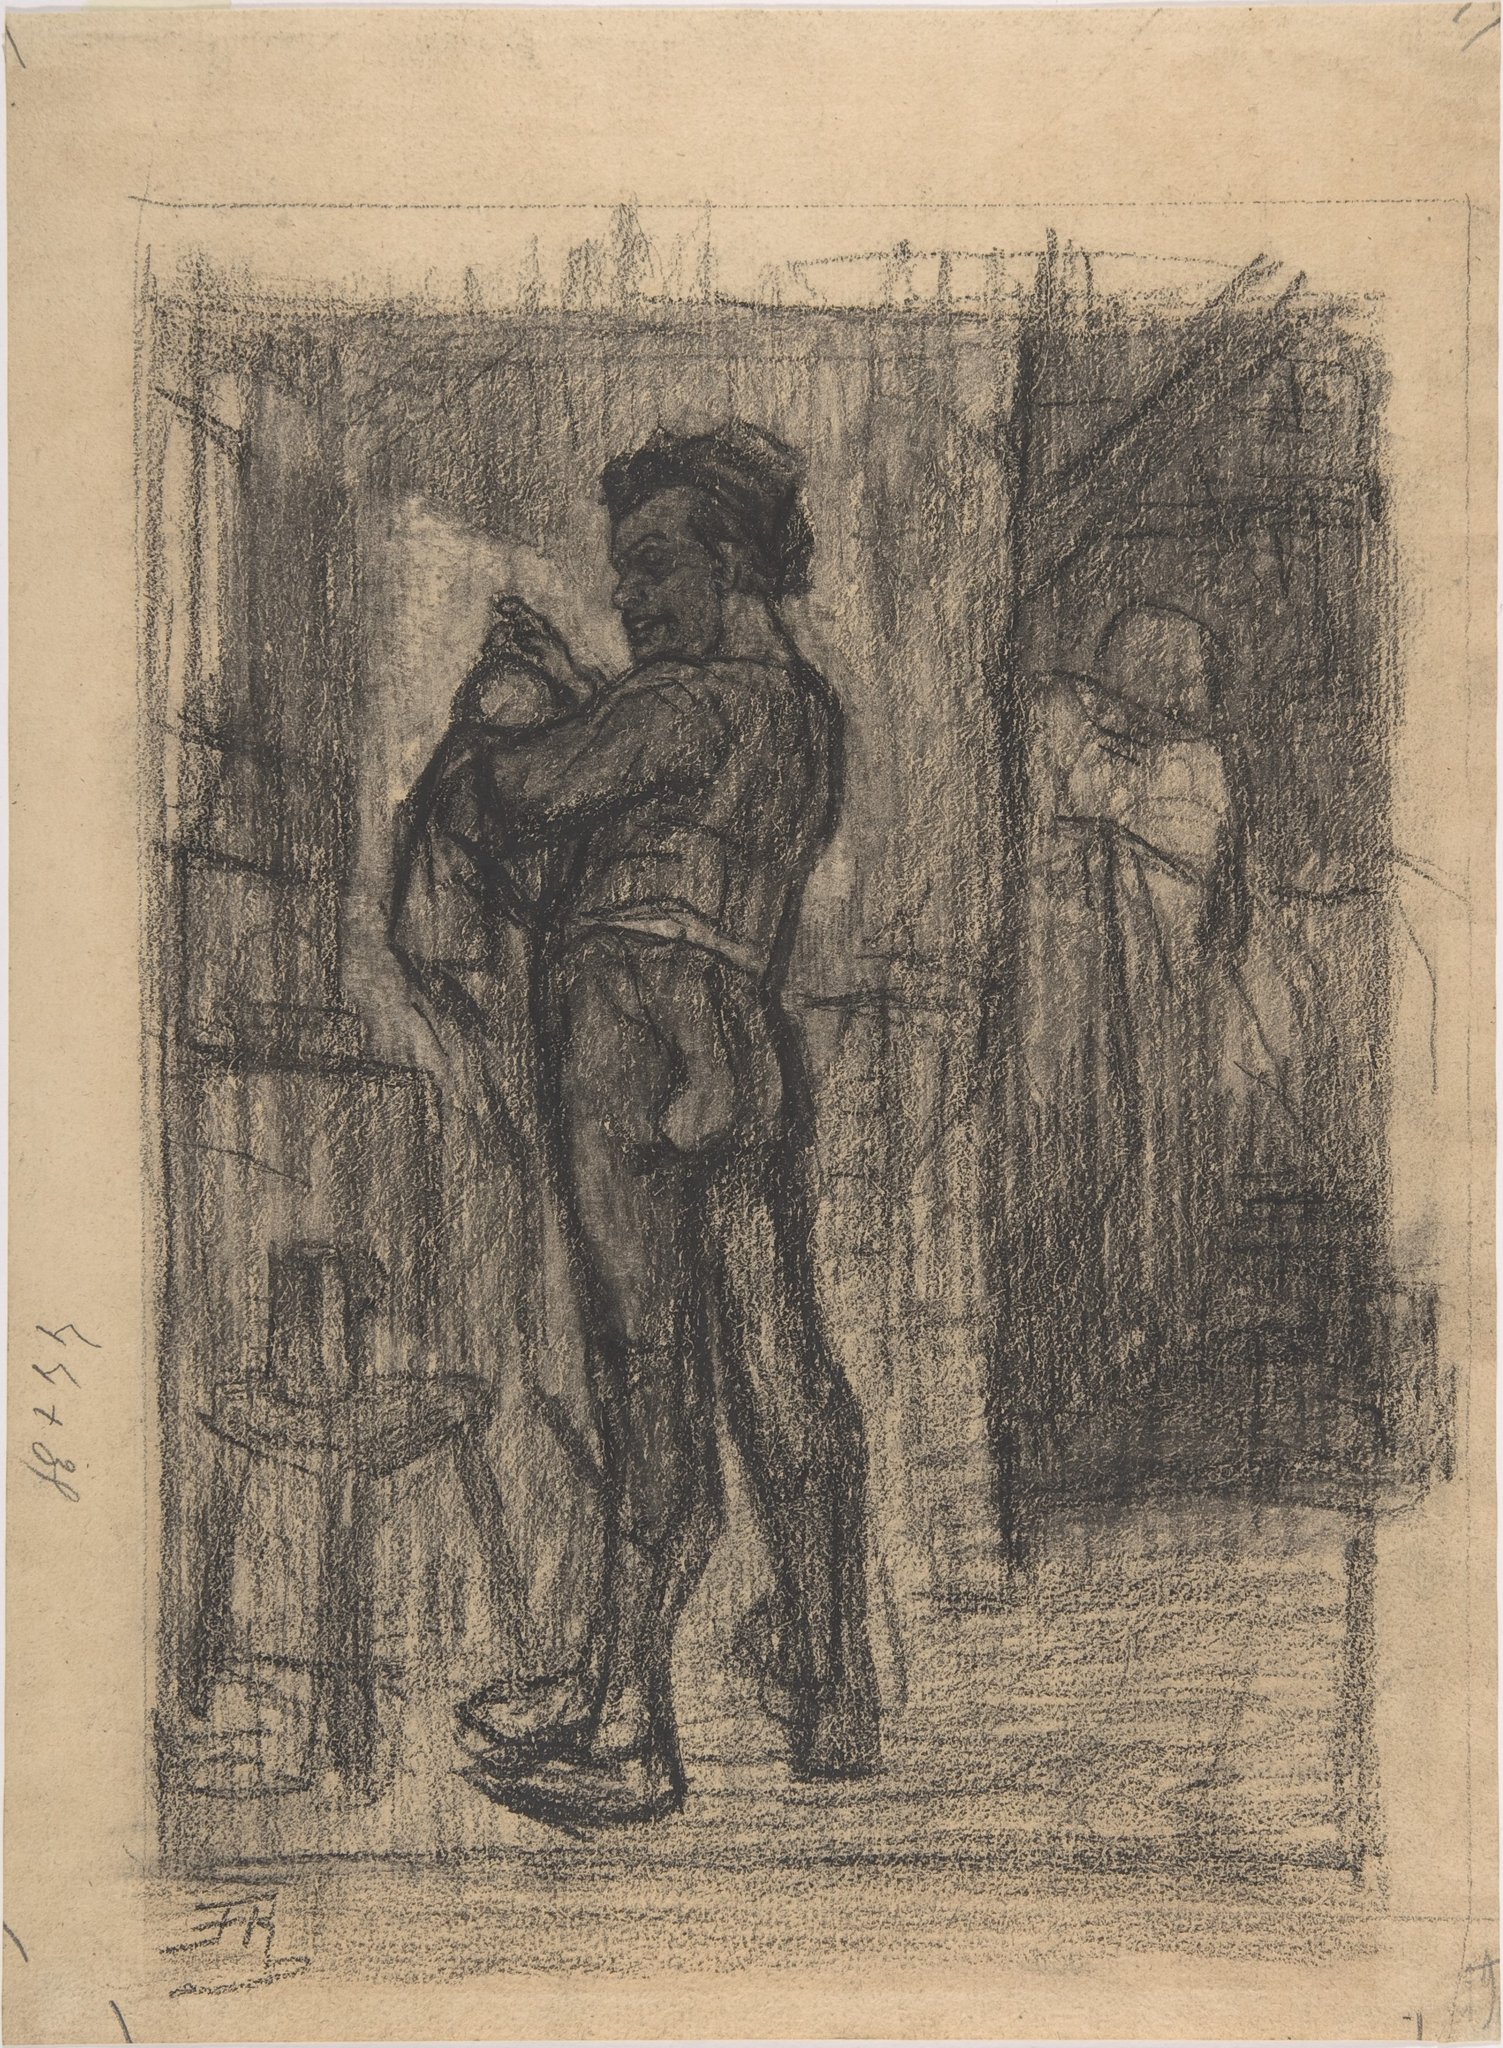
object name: drawing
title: Standing man with beer mugs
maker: félicien rops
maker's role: artist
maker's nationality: belgian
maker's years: 1833-1898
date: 1833-1898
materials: chalk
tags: men